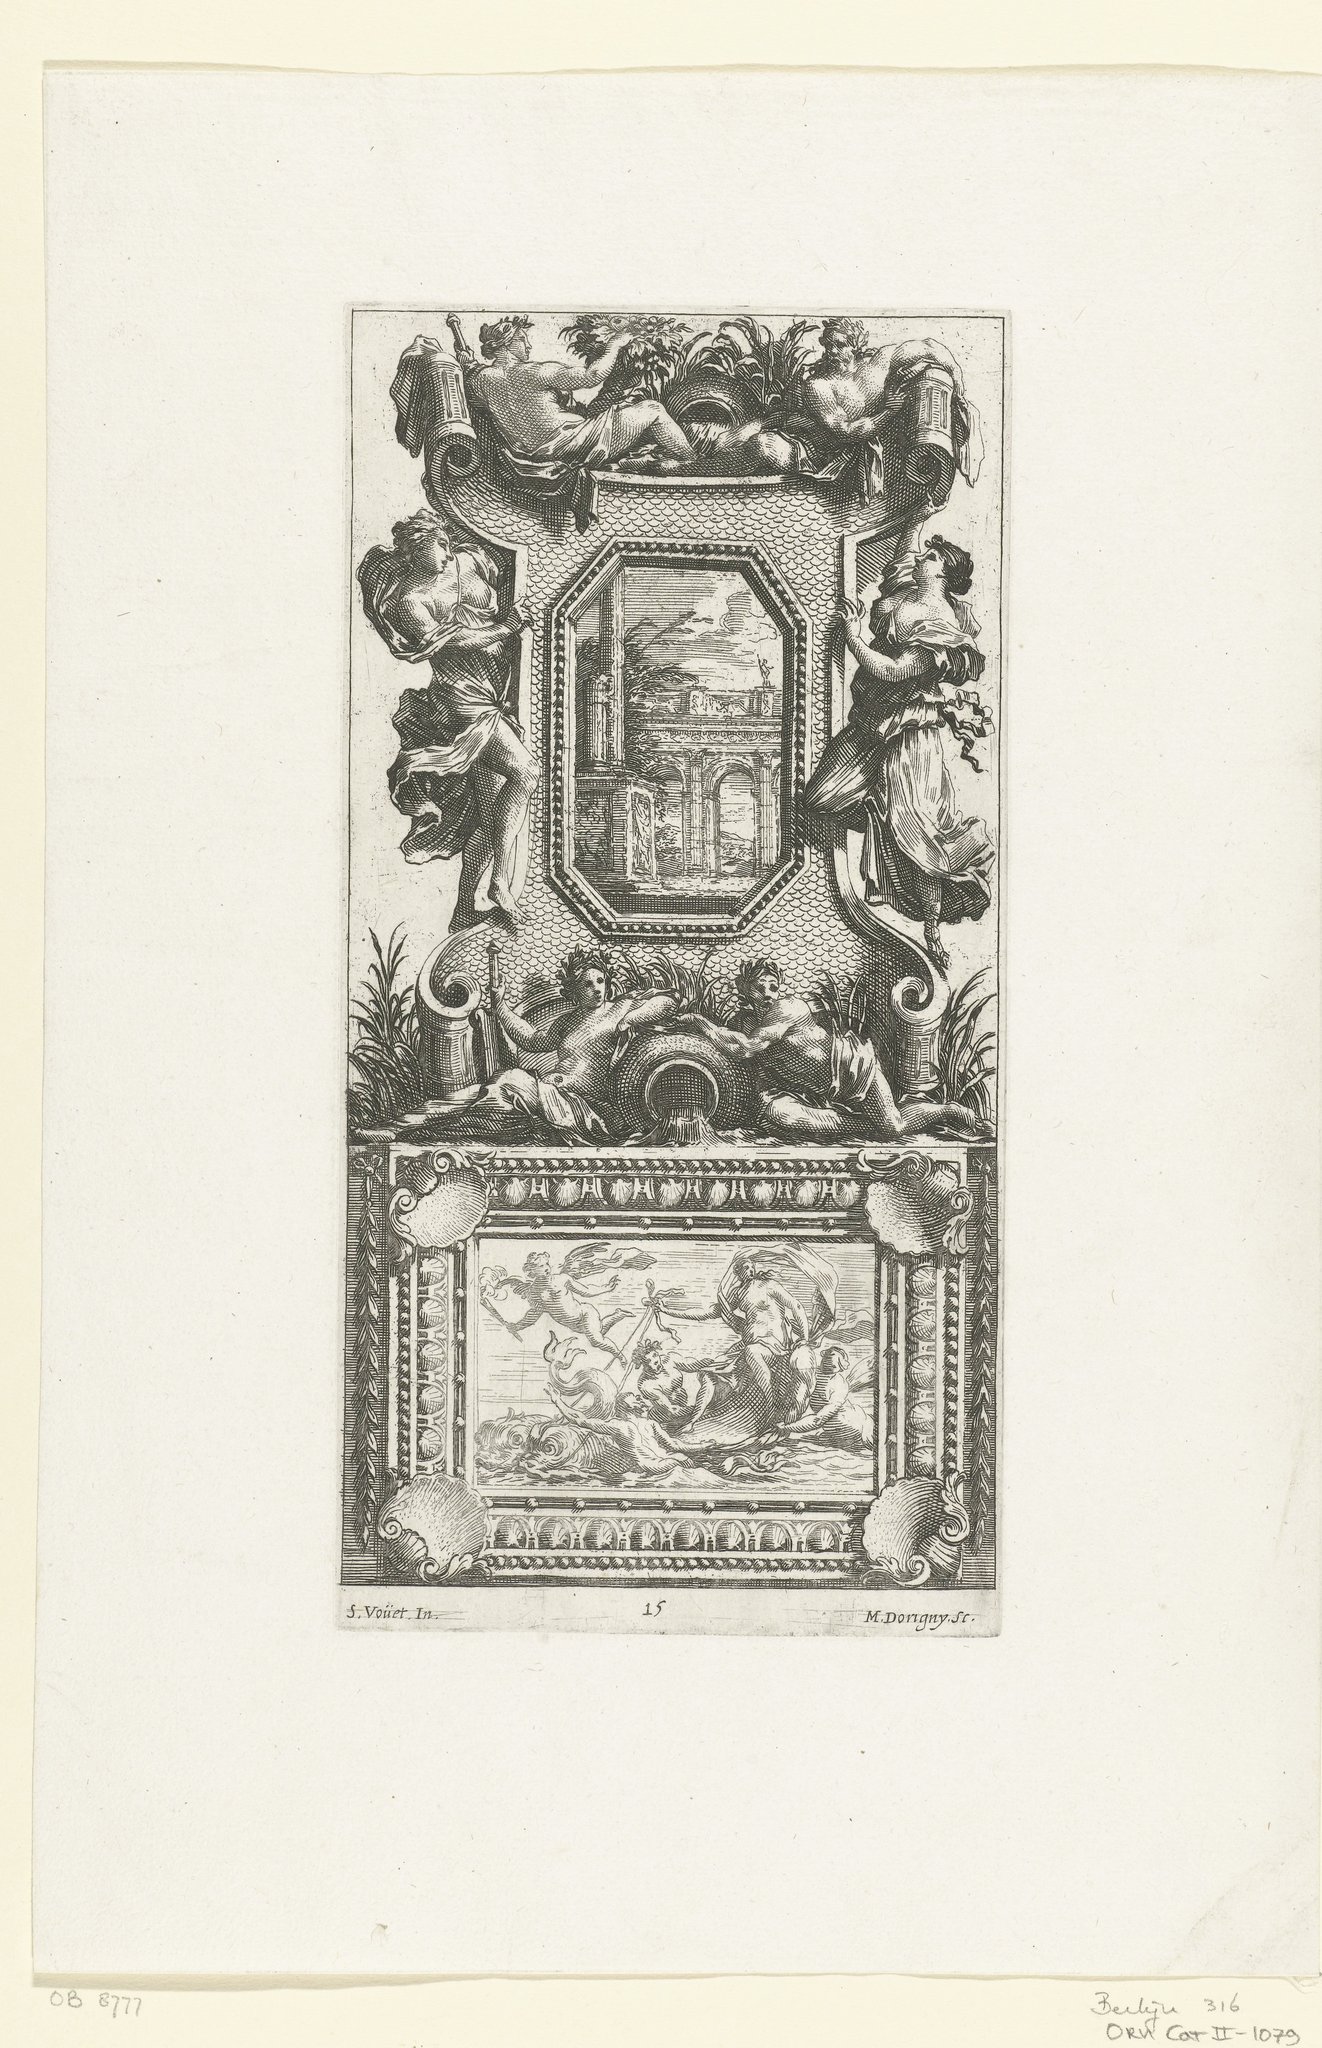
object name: print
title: Muurpaneel met cartouche geflankeerd door nimfen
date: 1647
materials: paper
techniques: engraving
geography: paris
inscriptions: collector's mark: Lugt 240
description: In het midden van de cartouche staat een lijst met een ruïne, daaronder liggen een riviergod en riviergodin naast een vaas.